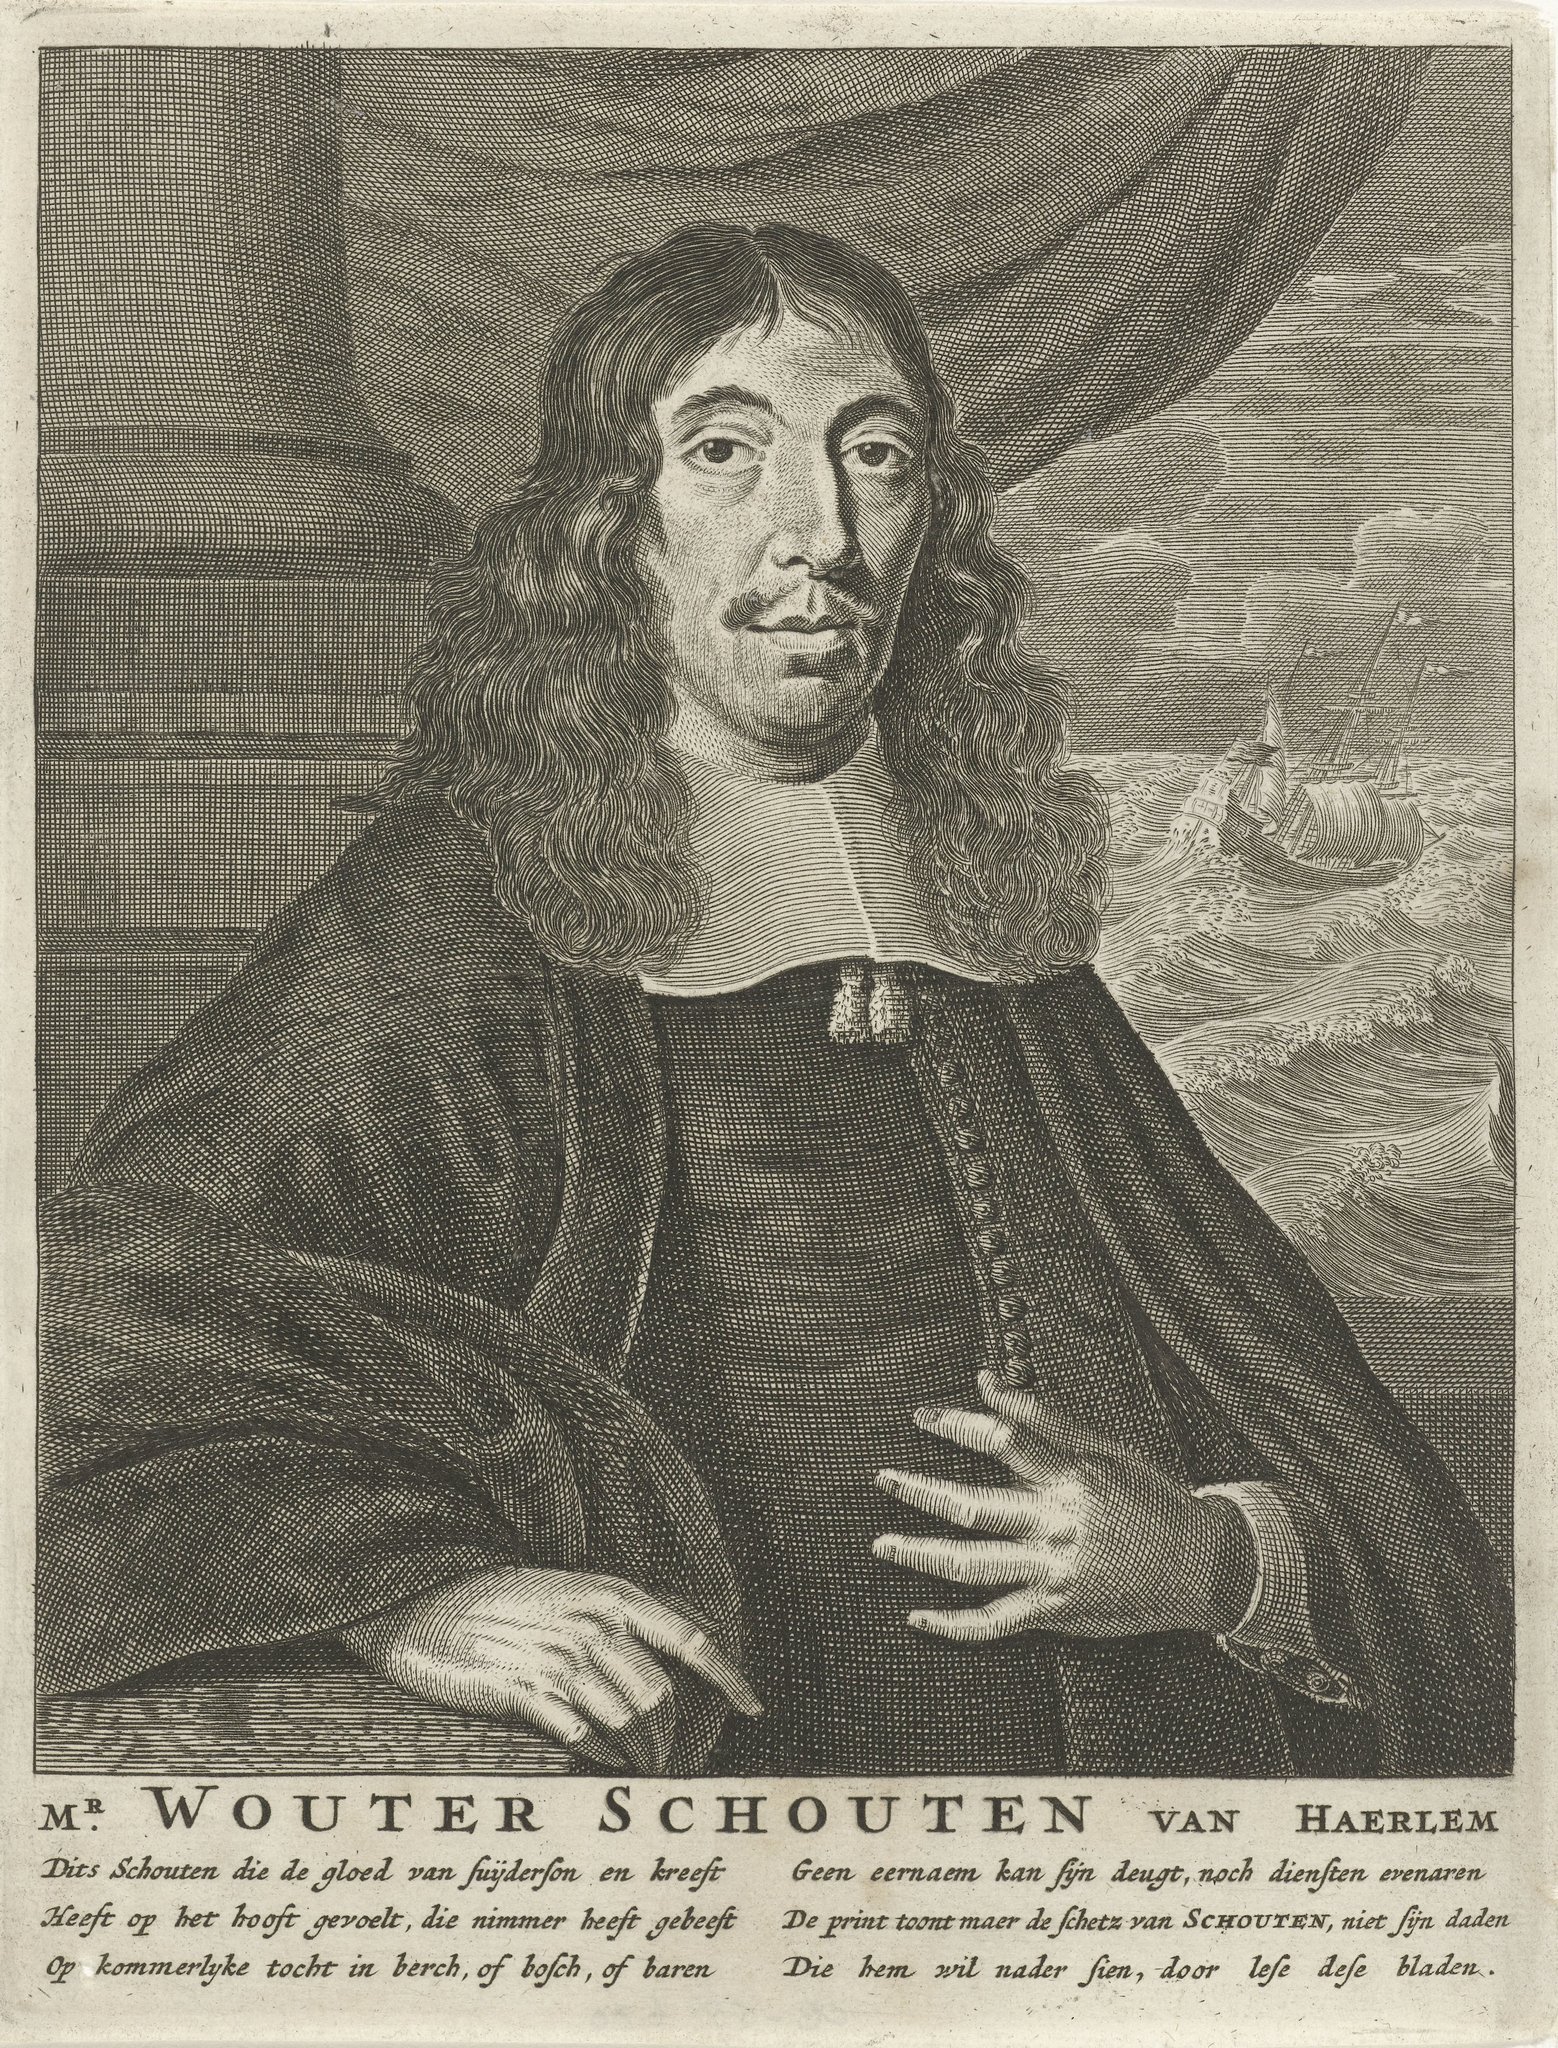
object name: print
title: Portret van Wouter Schouten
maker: christiaan hagen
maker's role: draughtsman, print maker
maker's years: 1635-1707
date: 1663-1676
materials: paper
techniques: engraving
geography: amsterdam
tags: haarlem, wouter schouten, sailing-ship, sailing-boat, styles of hairdress, storm at sea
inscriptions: collector's mark: Lugt 2228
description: Gebruikt als auteursportret in: Wouter Schouten, Oost-Indische voyagie; vervattende veel voorname voorvallen en ongemeene vreemde geschiedenissen [...] Mitsgaders een curieuse beschrijving der voornaemste landen, eylanden, koninckrijcken en steden [...] Als oock sijn seer gevaerlijcke wederom-reyse naer 't Vaderlandt [...] Verçiert met seer konstige koopere platen [...] door den scrijver in Indien self geteeckent, Amsterdam: Jacob van Meurs en Johannes von Sommern 1676.